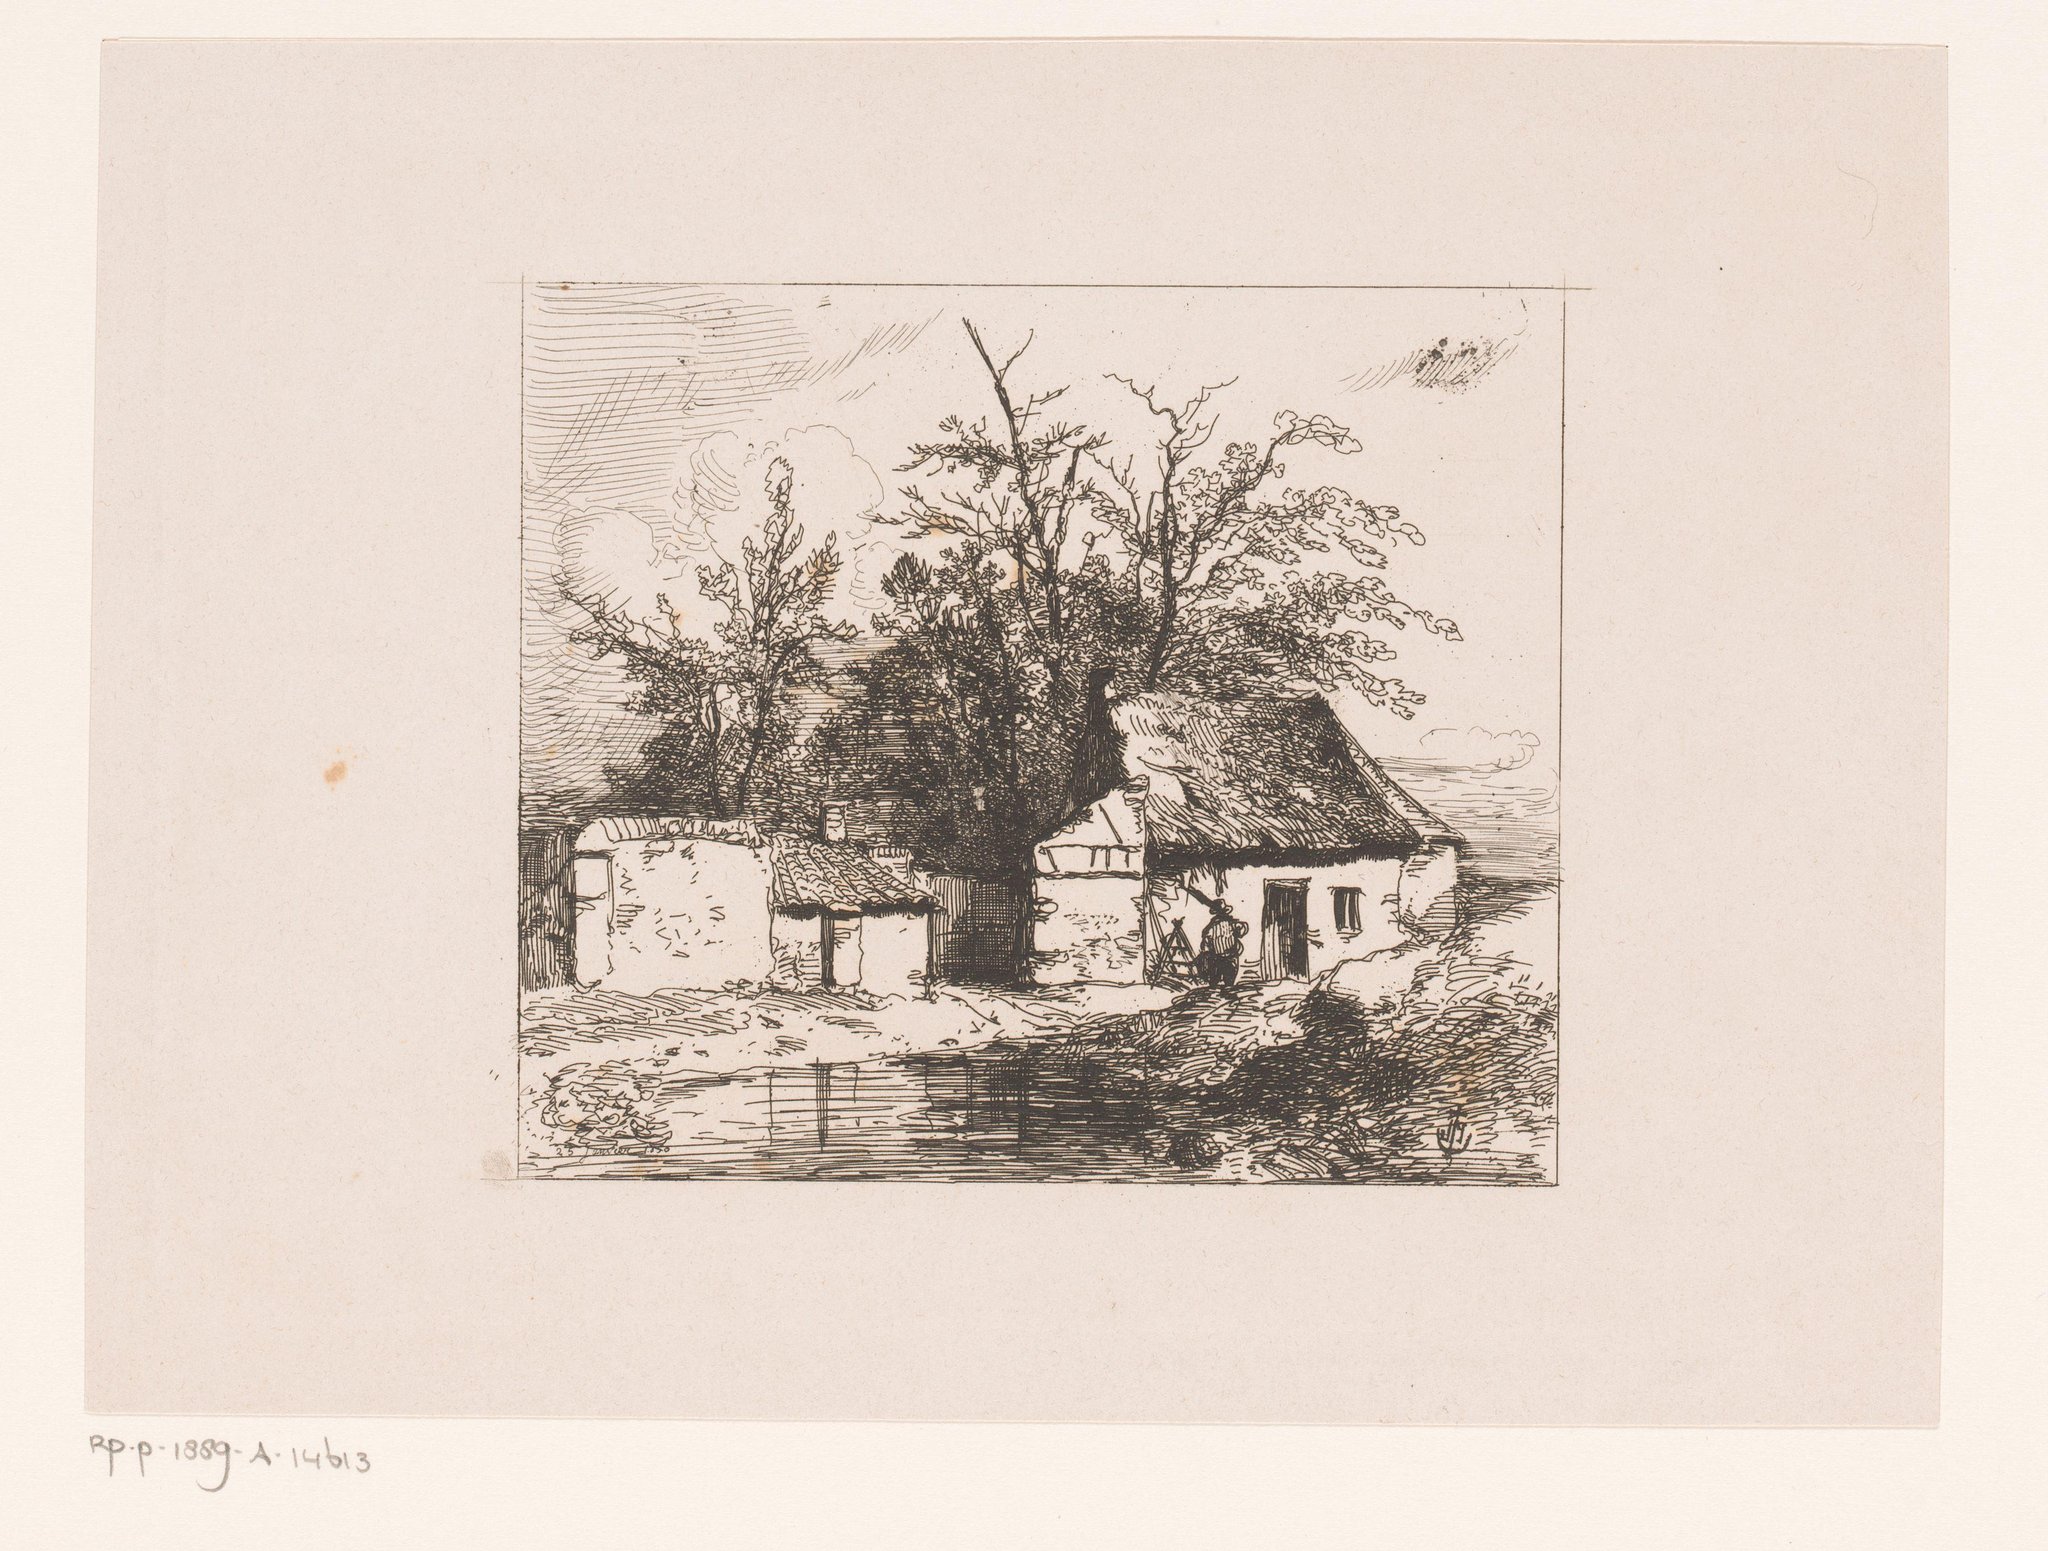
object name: print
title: Gezicht op een kleine rietgedekte woning met een beek op de voorgrond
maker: paulus lauters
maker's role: print maker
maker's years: 1806-1875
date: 1816-1875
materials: paper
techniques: etching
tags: farm or solitary house in landscape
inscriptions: collector's mark: Lugt 2228